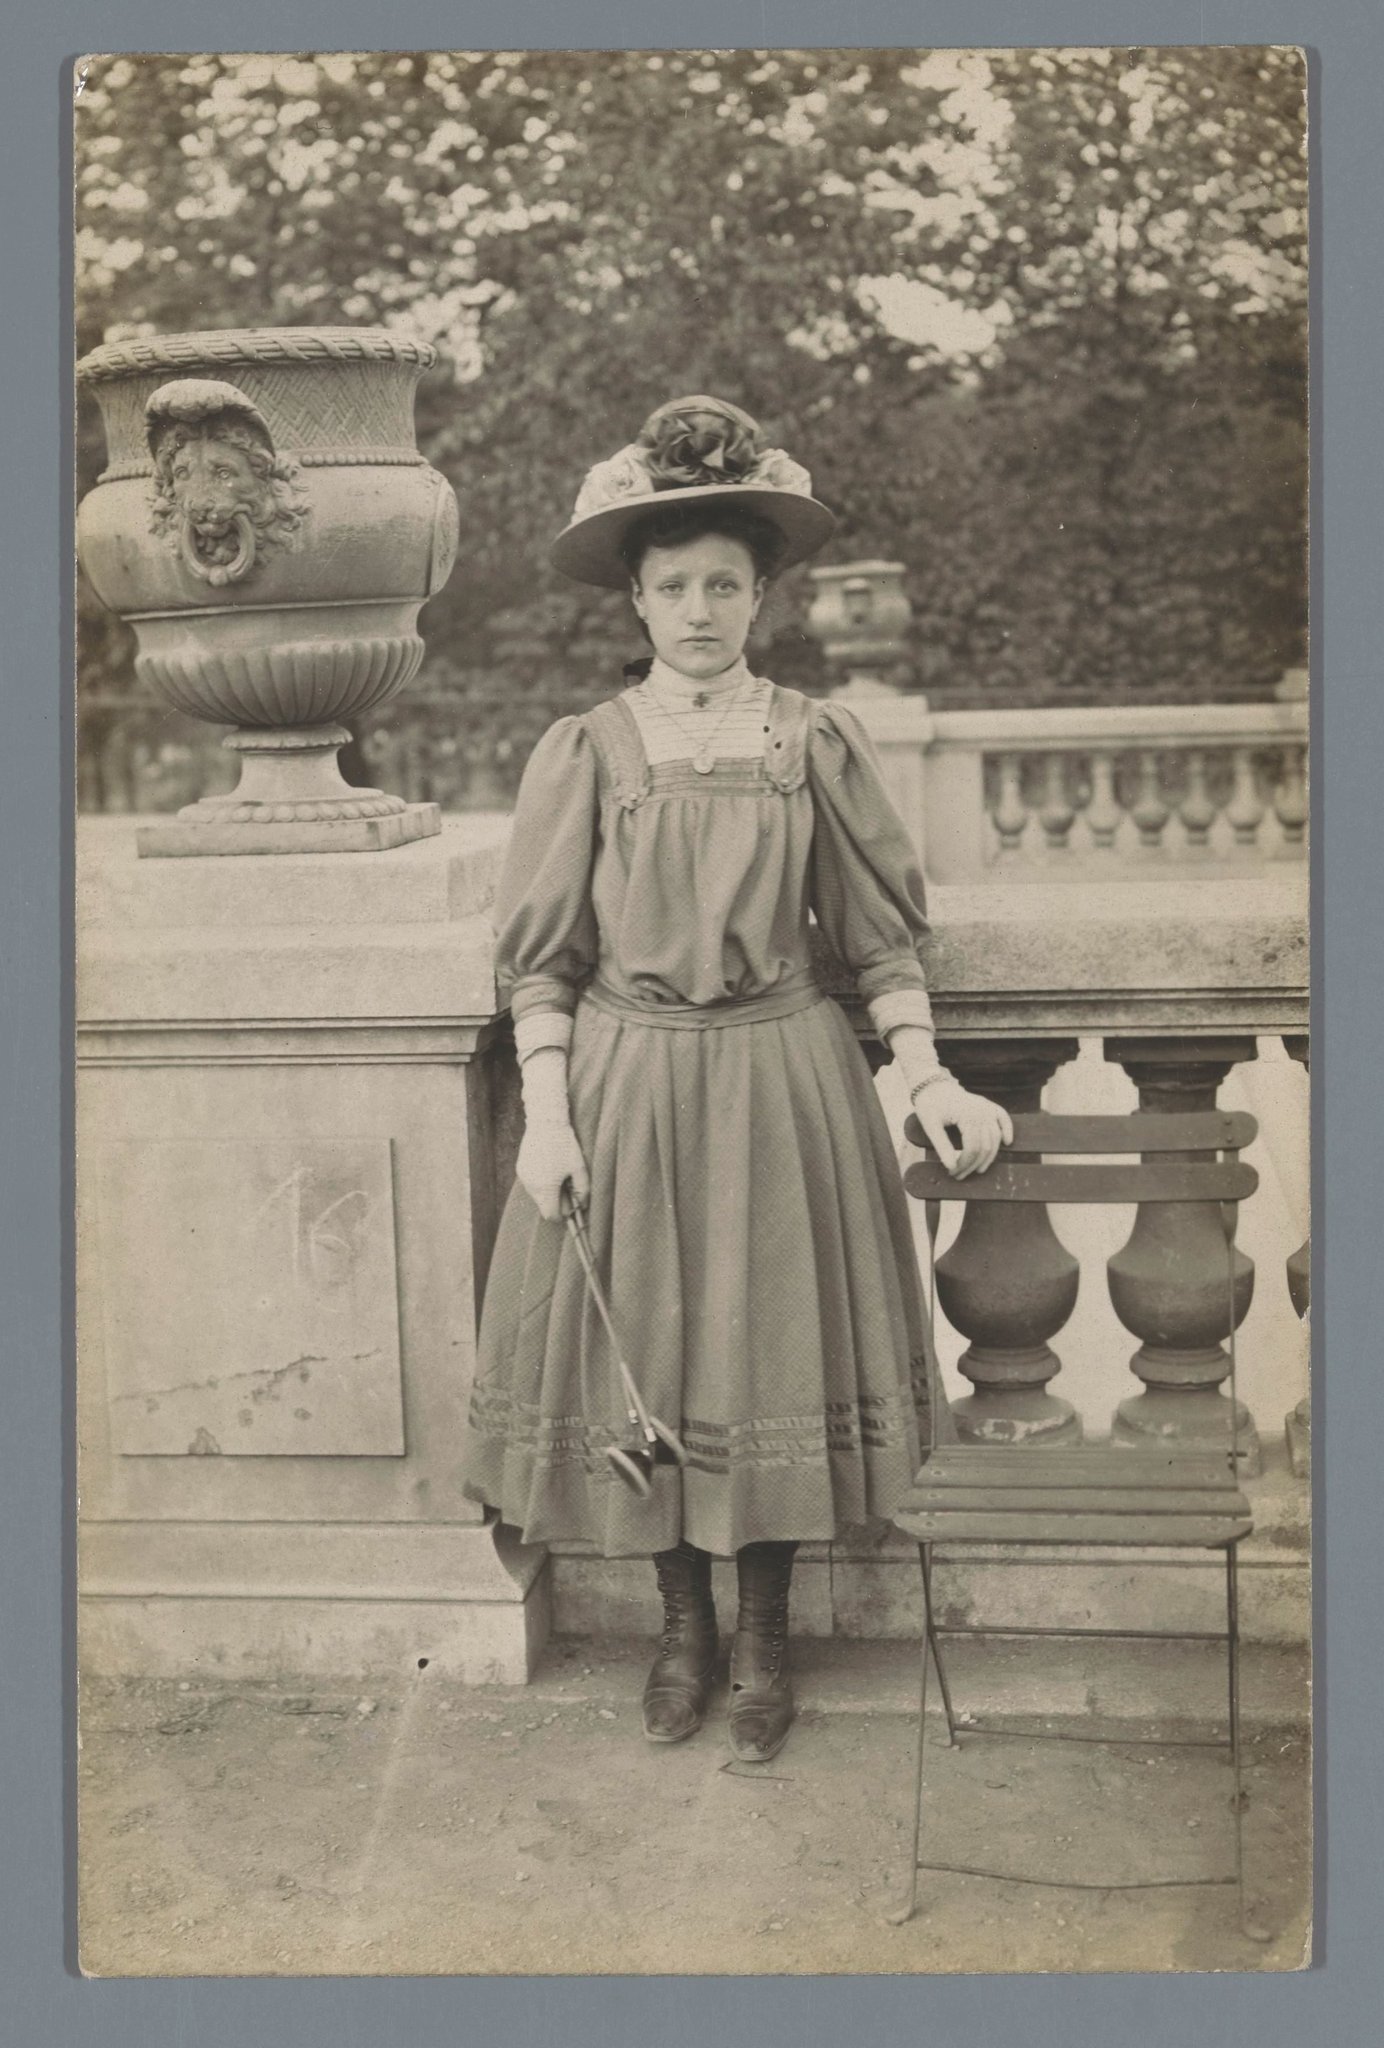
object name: ansichtkaart, prentbriefkaart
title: Portret van een onbekend meisje met een diabolo (vermoedelijk) in een park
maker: Anonymous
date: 1907-1920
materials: photographic support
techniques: gelatin silver print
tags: park, adolescent, young woman, maiden, air top, diabolo, devil-on-two-sticks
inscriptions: number: ‘250’